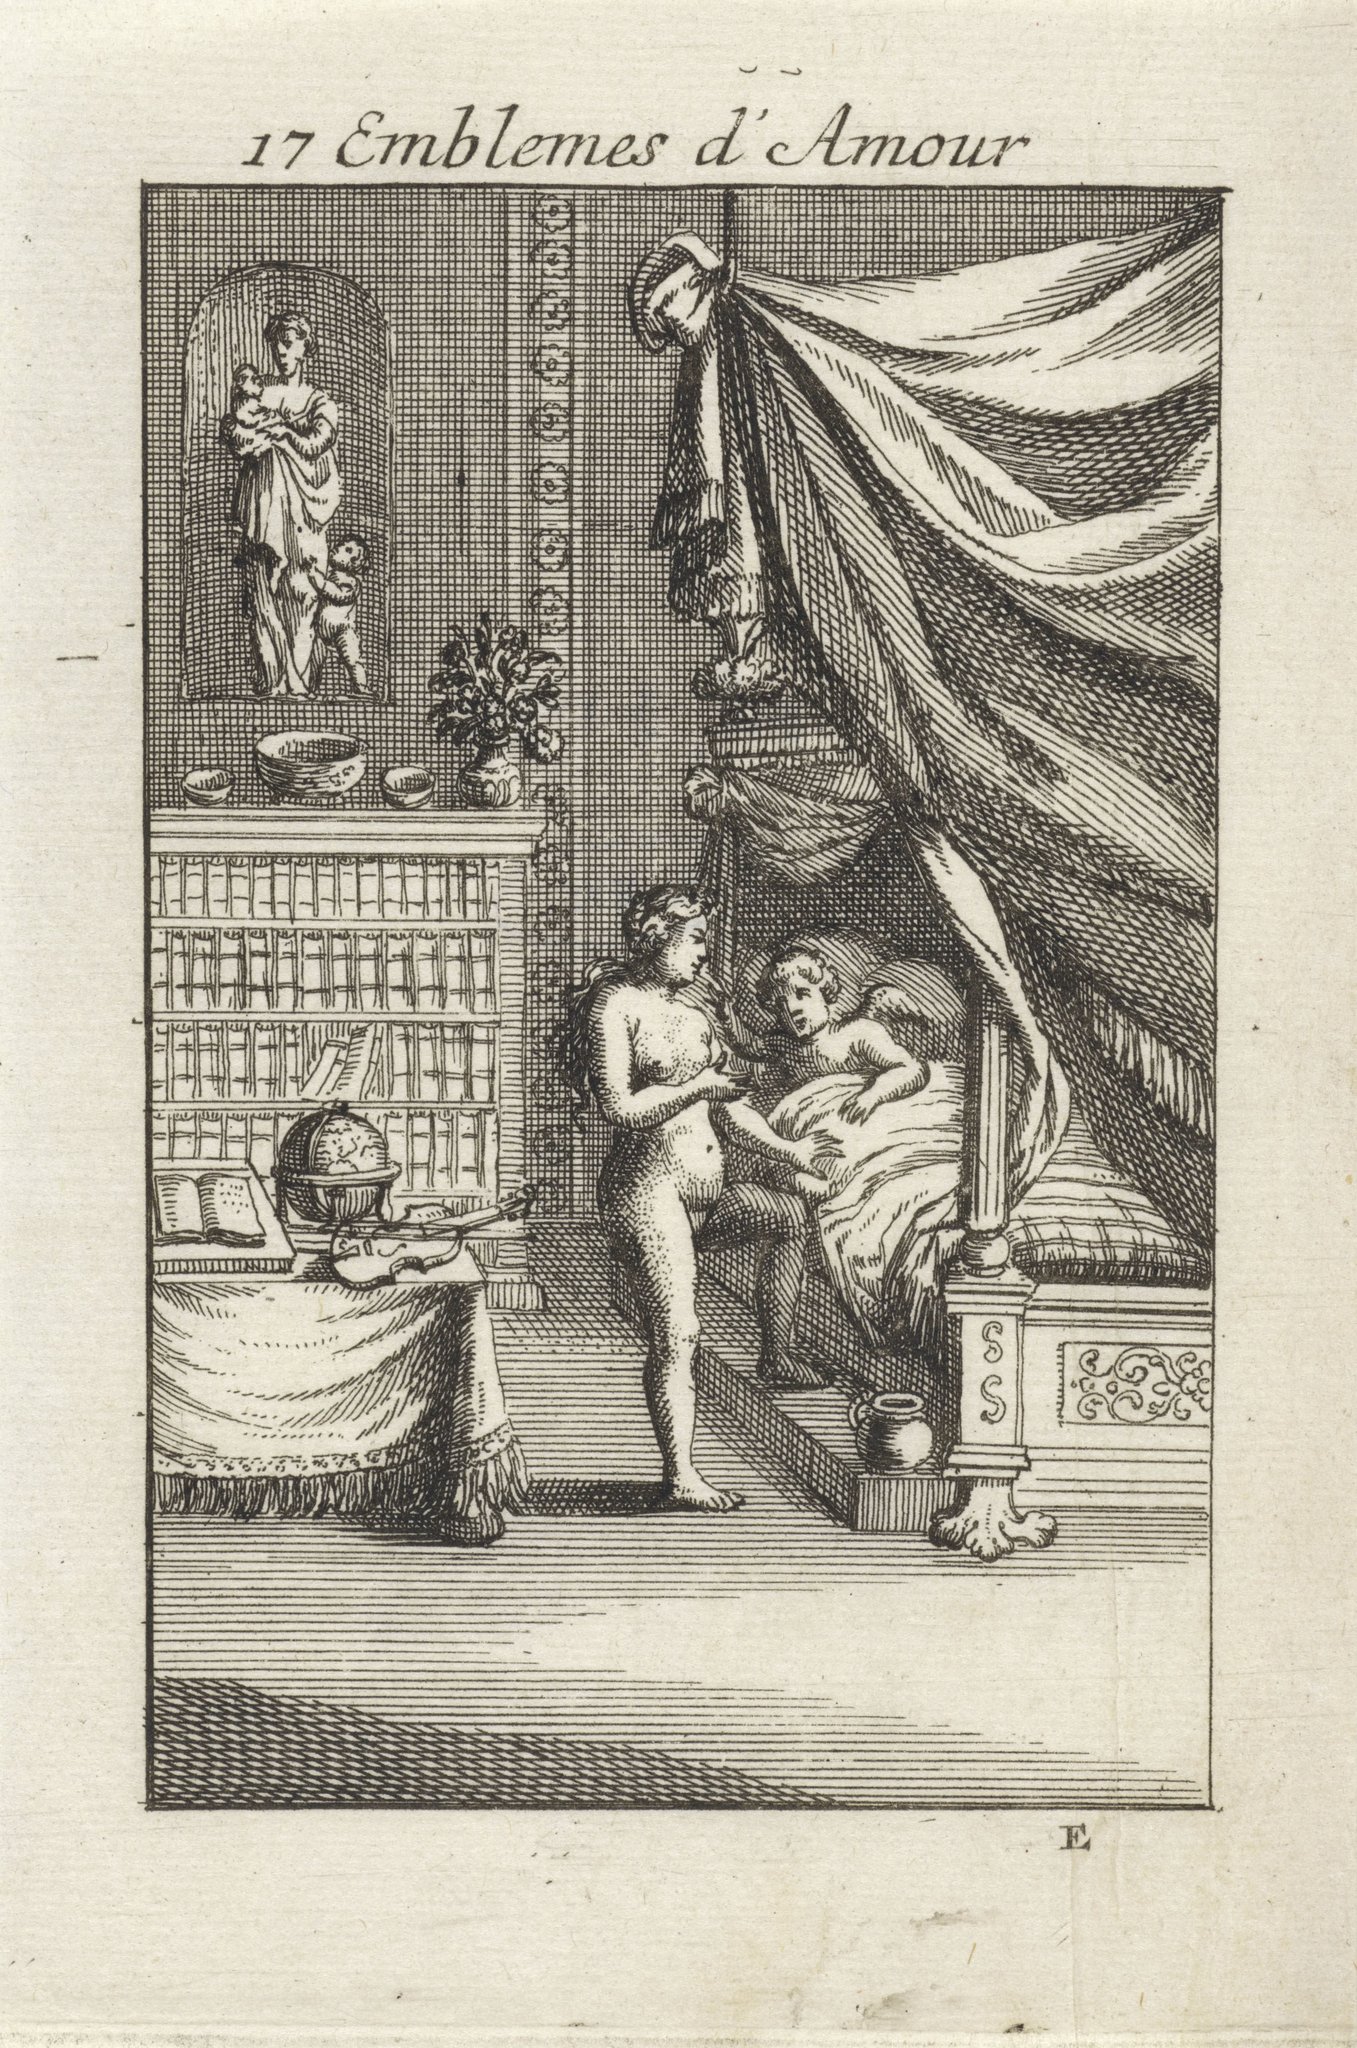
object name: print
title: Emblemes d'Amour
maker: jan van vianen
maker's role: print maker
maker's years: 1660-1726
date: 1686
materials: paper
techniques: engraving, etching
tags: (story of) cupid, amor (eros)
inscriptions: collector's mark: Lugt 2228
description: Amor ligt in een bed, waar een vrouw in stapt om te gaan slapen. In gelukkige dromen kunnen geliefden zich bij elkaar wanen. Zeventiende embleem uit Emblemata Amatoria.